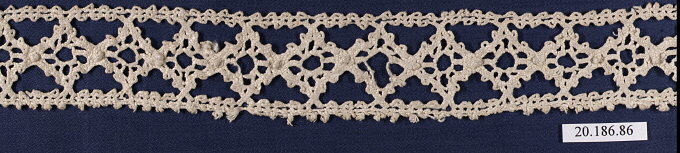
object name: insertion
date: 1501-1600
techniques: lace